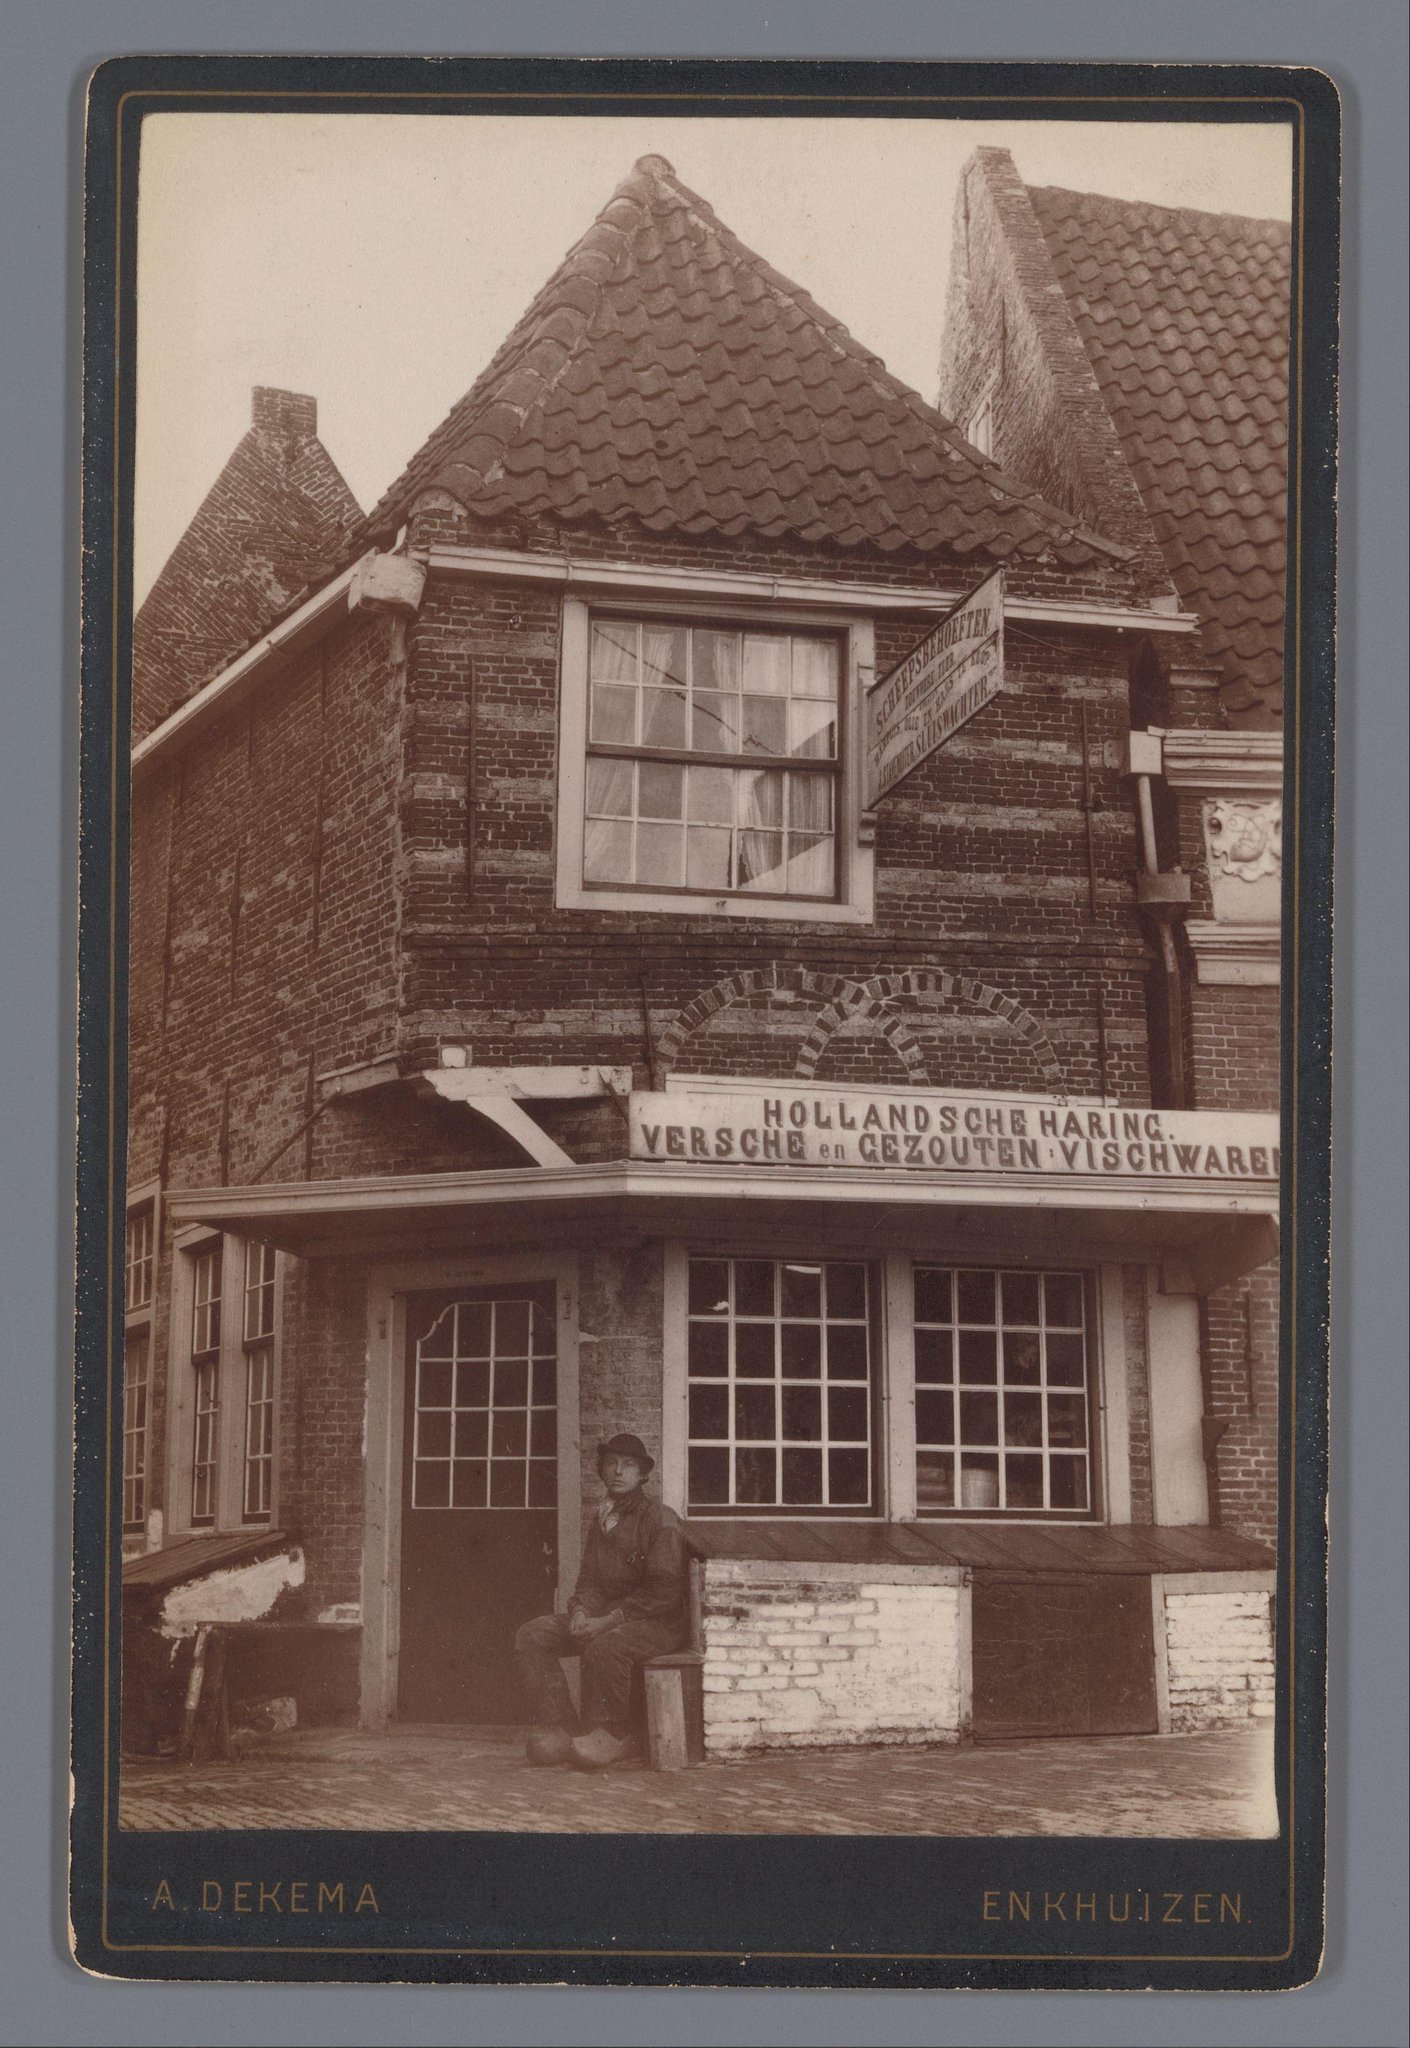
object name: photograph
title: Façade van een winkel in scheepsbehoeften te Enkhuizen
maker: albert dekema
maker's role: publisher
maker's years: 1824-1909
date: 1865-1896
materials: cardboard, photographic support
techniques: albumen print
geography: enkhuizen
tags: shop, store, façade (of house or building), enkhuizen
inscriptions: inscription: ‘A. Dekema/ Enkhuizen’